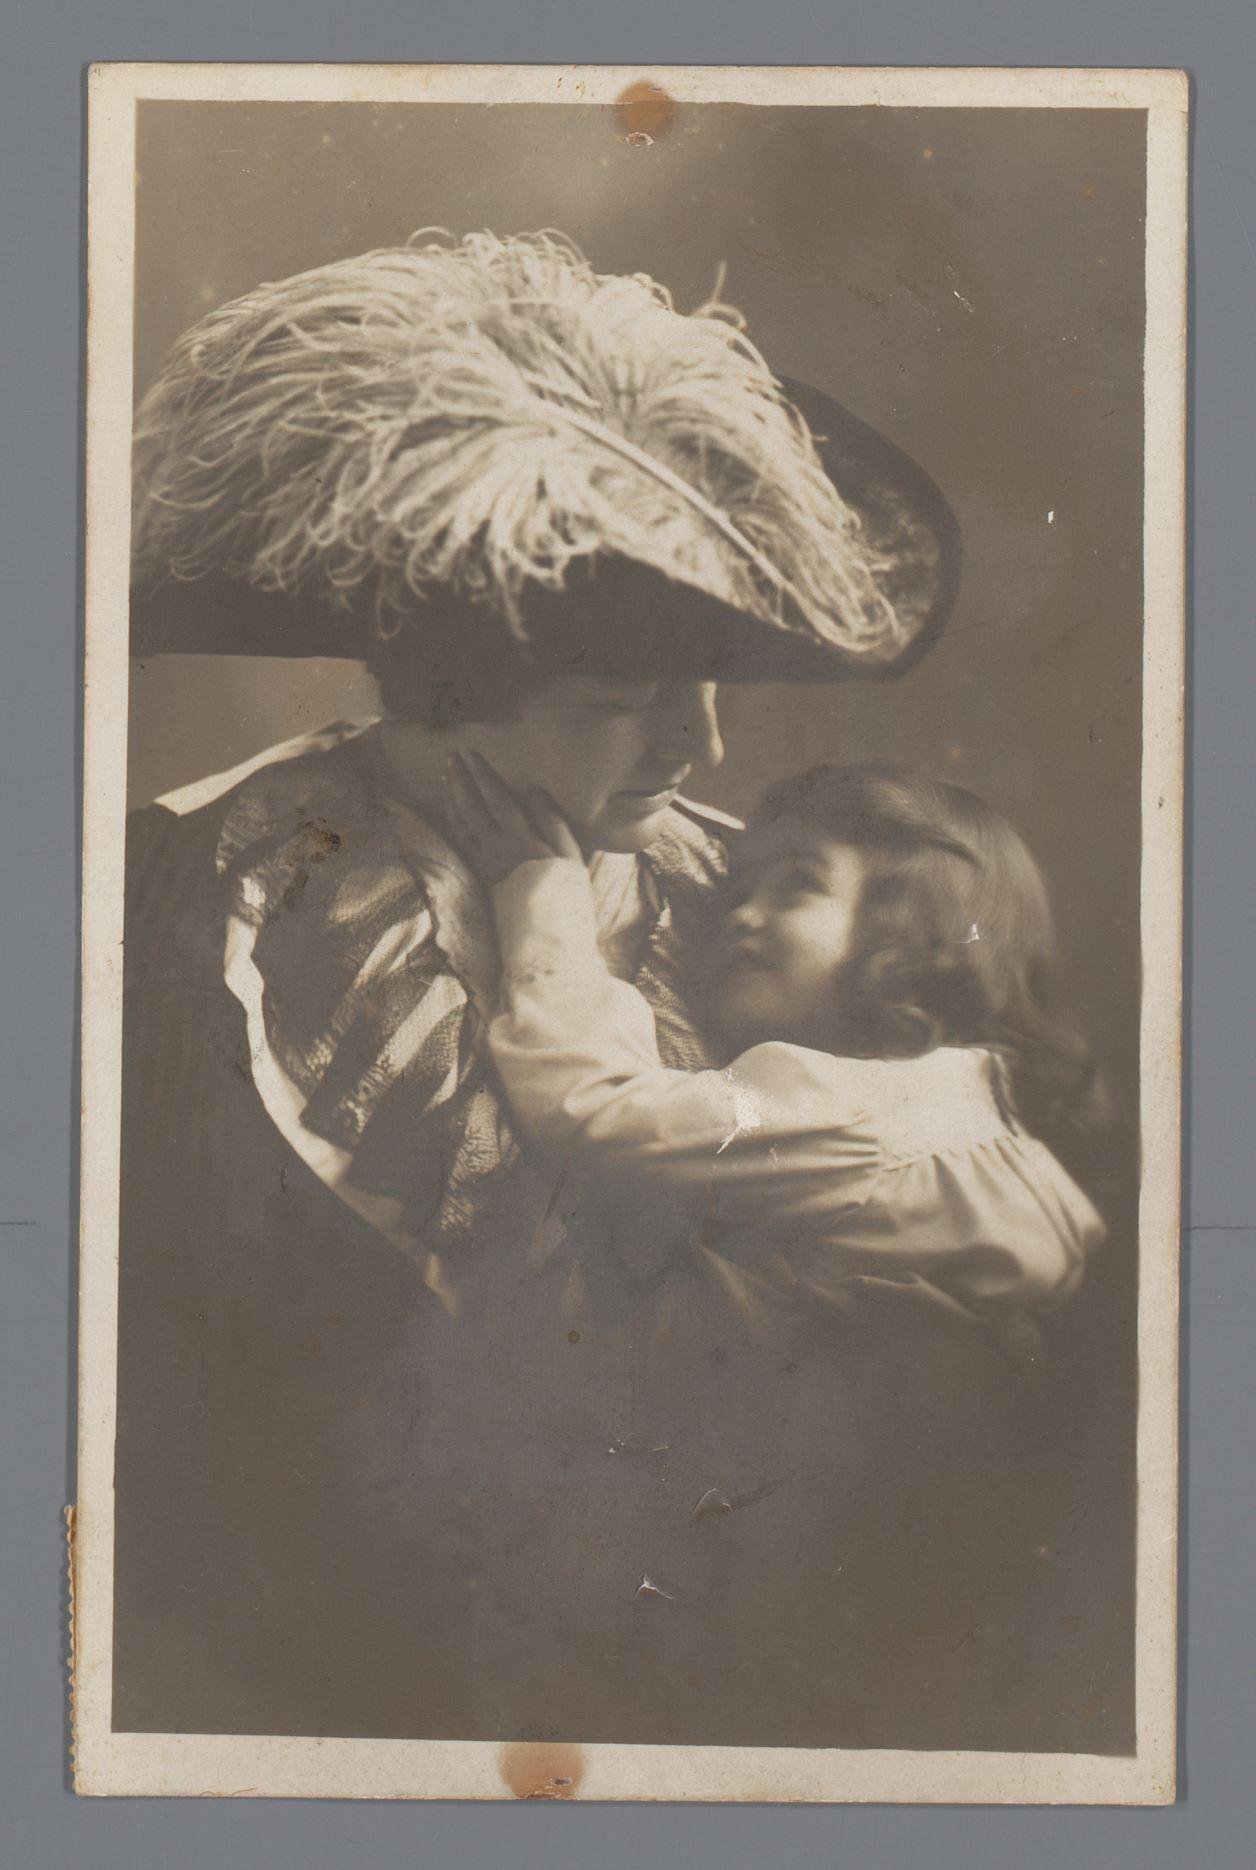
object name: ansichtkaart, prentbriefkaart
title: Prentbriefkaart met foto van een moeder met hoed en een kind in haar armen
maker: Anonymous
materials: cardboard, paper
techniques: gelatin silver print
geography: brussels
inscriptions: stamp: ‘Brussel//Bruxelles//18-19 5 XII 1912’, annotation: ‘Mademoiselle B. Wolter//30 rue de l'Abbaye//Bruxelles’, inscription: ‘PHOTO COMPAGNIE BELGE, BRUXELLES, 109, rue Neuve.//Succ.: 29, chaussee d'Ixelles; 6 rue de la Bourse;//214 rue de Brabant,//MARSEILLES; 75, rue St. Ferréol.’, annotation: ‘Petit souvenir d'amitié’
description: Geschreven en verstuurde prentbriefkaart met foto van een vrouw met een grote hoed met struisvogelveer en een meisje met halflang bruin haar in haar armen.